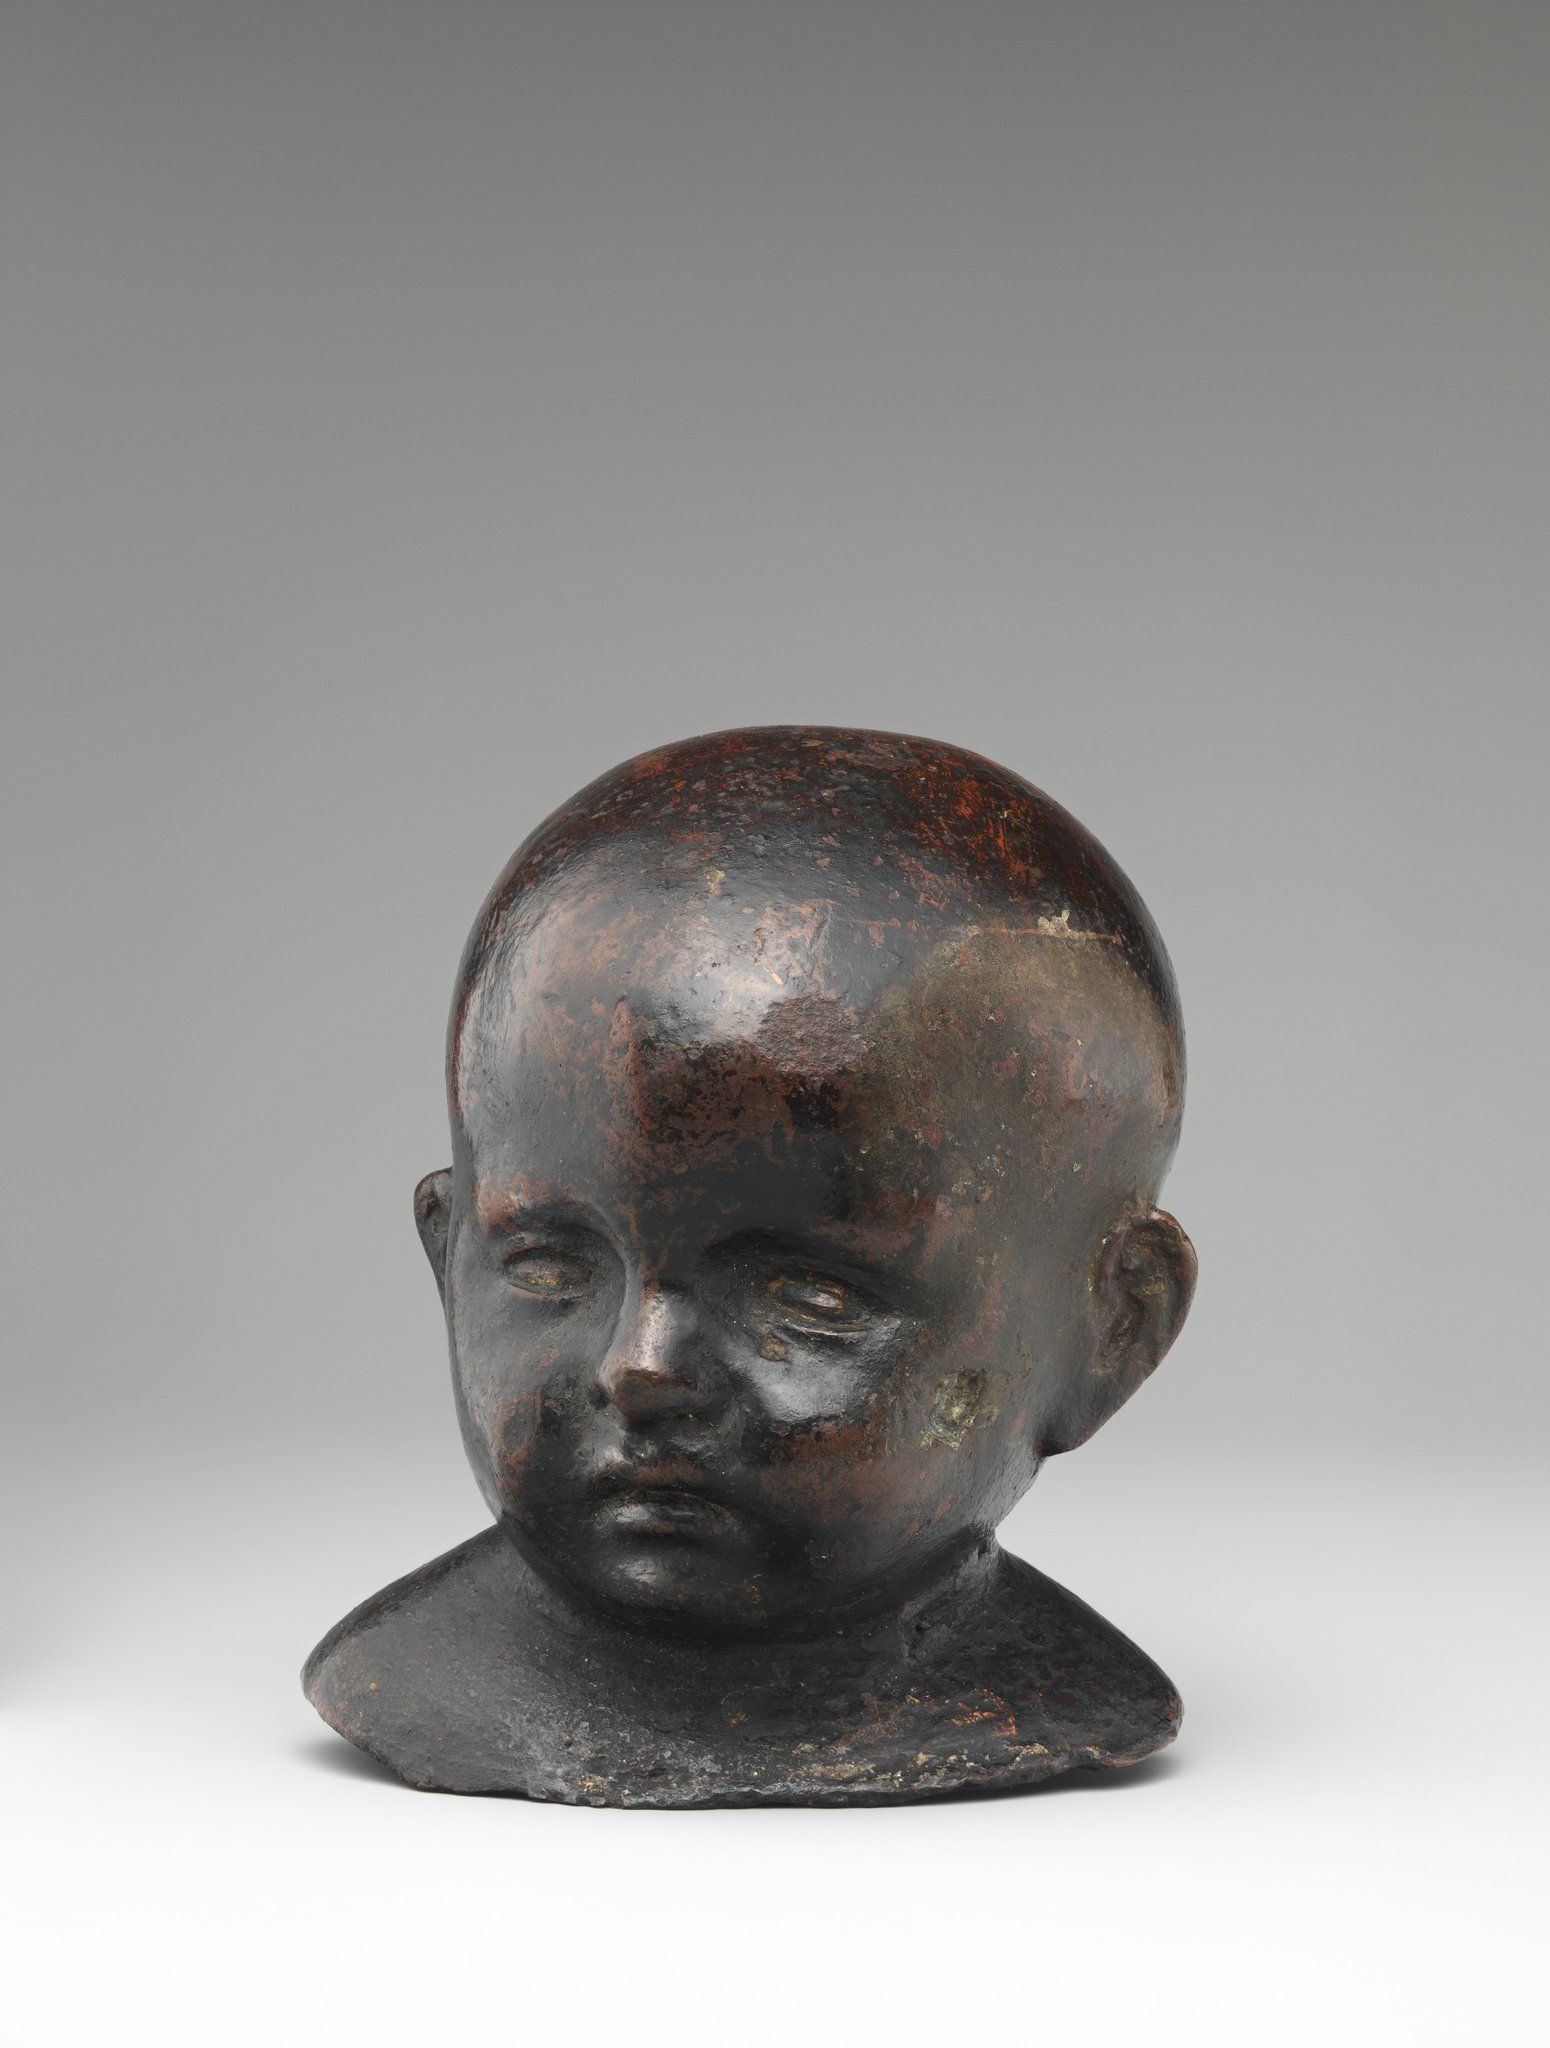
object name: head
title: Head of an Infant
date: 1801-1900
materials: bronze, marble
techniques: polish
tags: heads,children